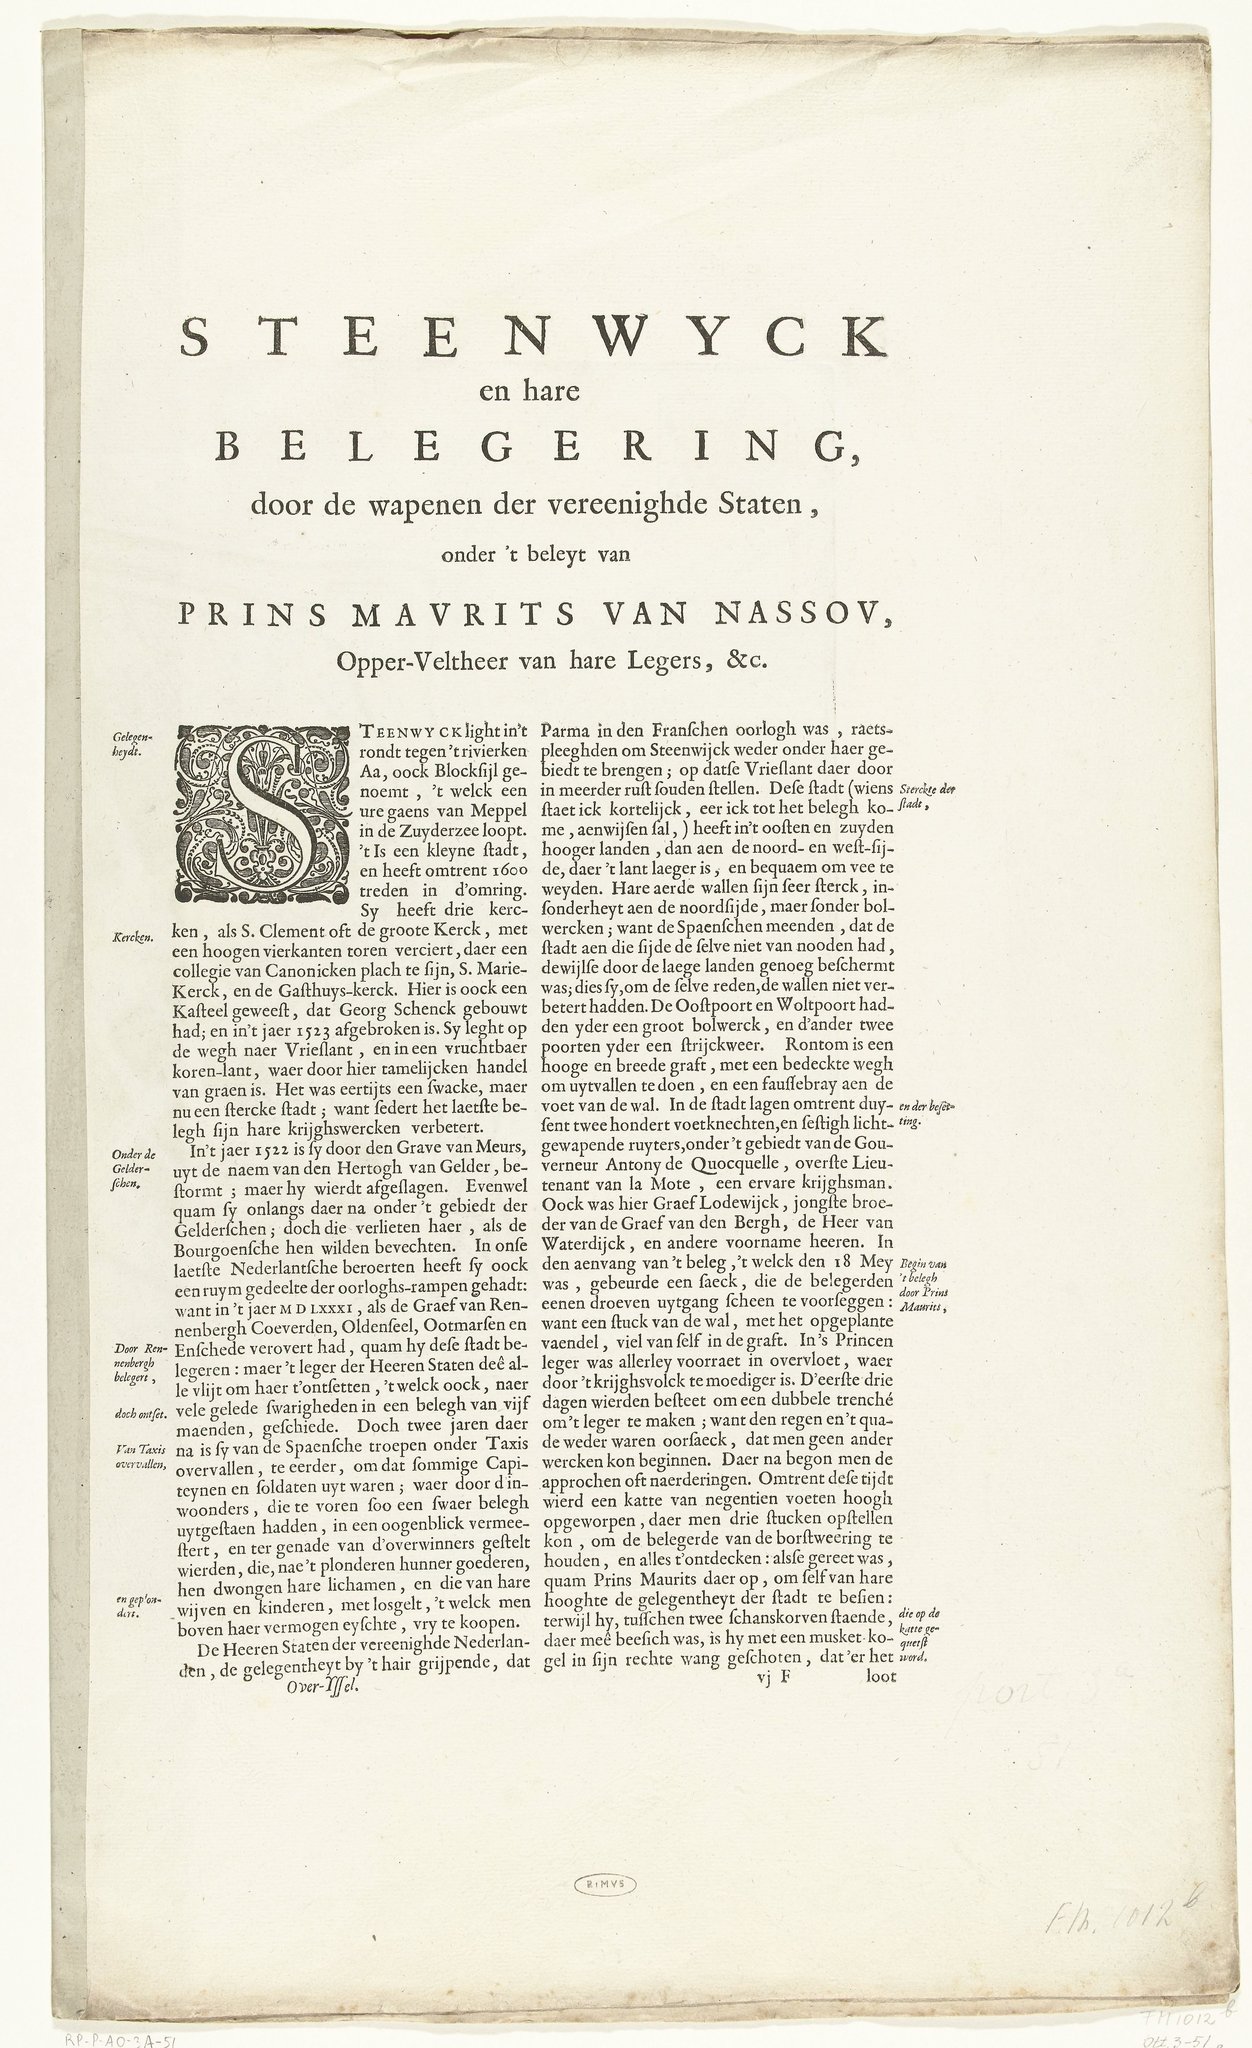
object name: history print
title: Kaart van het belegerde Steenwijk, 1592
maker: Anonymous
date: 1647-1649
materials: paper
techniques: etching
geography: northern netherlands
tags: the hague, maurice (prince of orange), siege, position war, maps of cities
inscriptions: collector's mark: Lugt 195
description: Kaart van Steenwijk belegerd door het Staatse leger onder Maurits, mei - juli 1592. Plan van Steenwijk met de stadswallen en verdedigingswerken en de posities van de belegerende troepen. In de stad zijn alleen twee kerken en enkele straten aangegeven. Bij de stadmuren twee explosies. Op een dubbelblad uit het Stedenboek van Blaeu genomen, op beide zijden bedrukt met tekst in het Nederlands, met 2 extra tekstbladen.